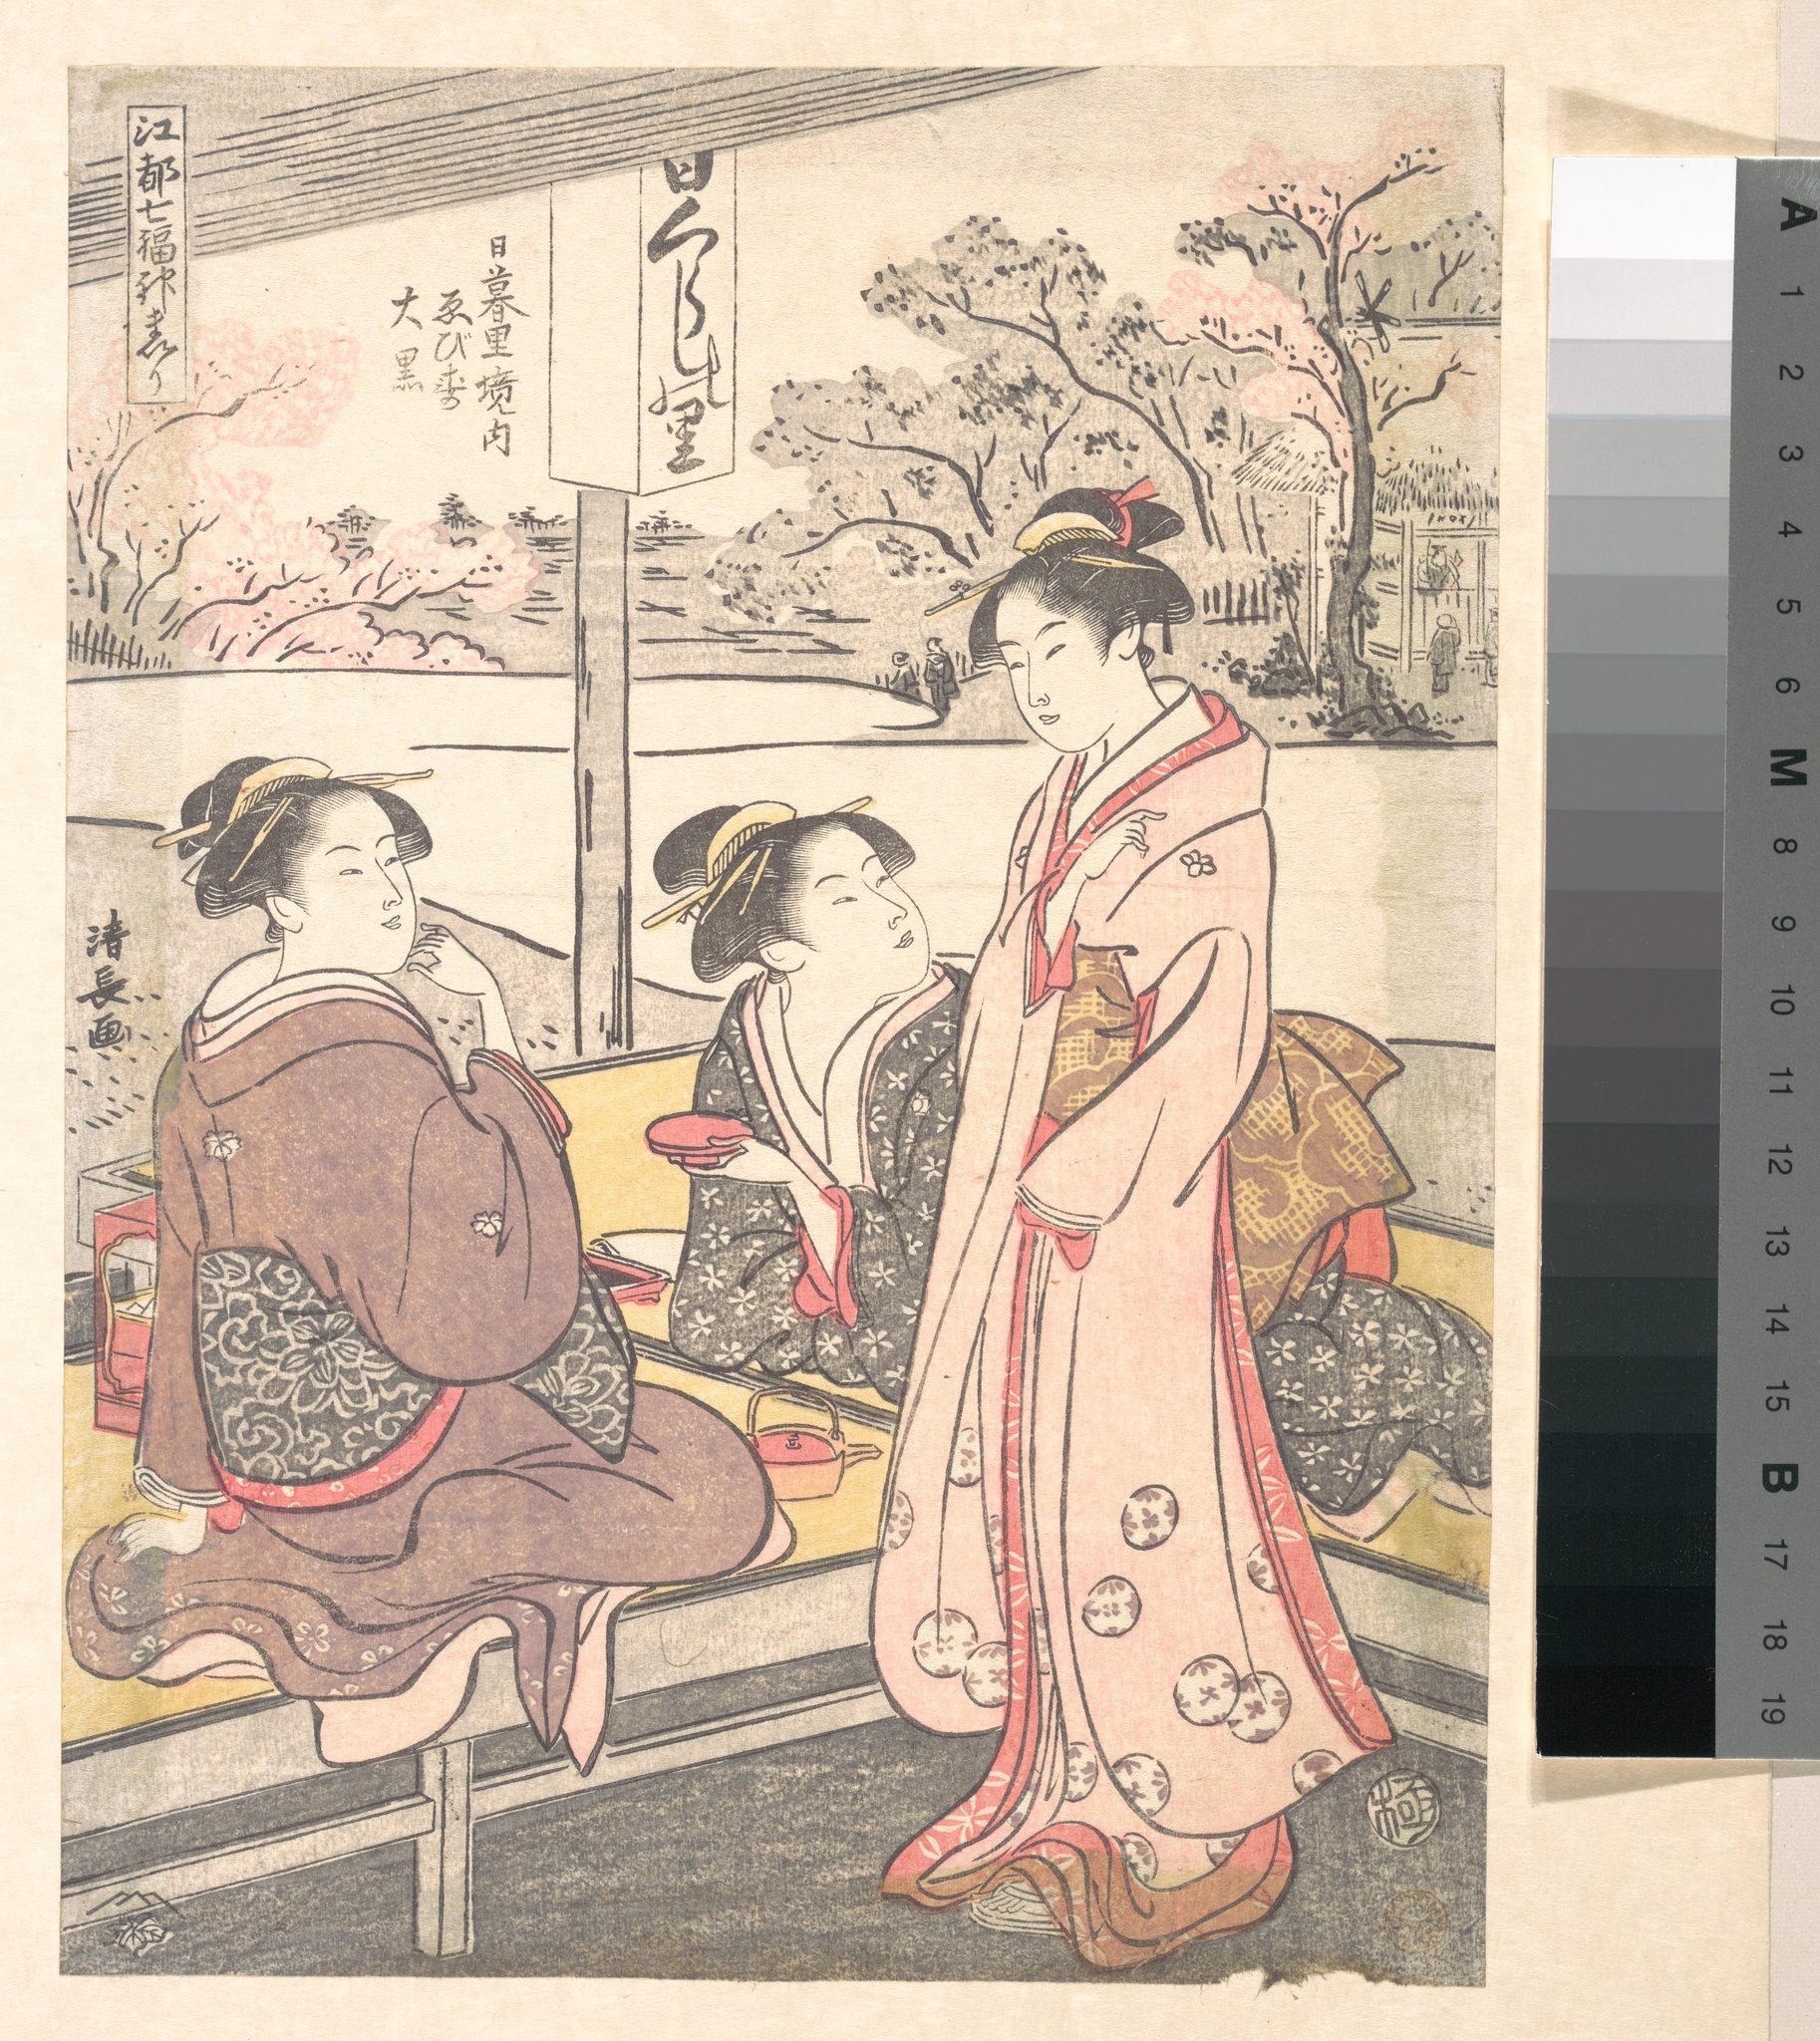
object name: print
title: Nippori Keinai Ebisu-Daikoku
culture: japanese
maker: torii kiyonaga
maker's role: artist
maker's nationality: japanese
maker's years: 1752-1815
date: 1793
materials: ink, paper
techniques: woodblock print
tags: women,drinking,tea houses